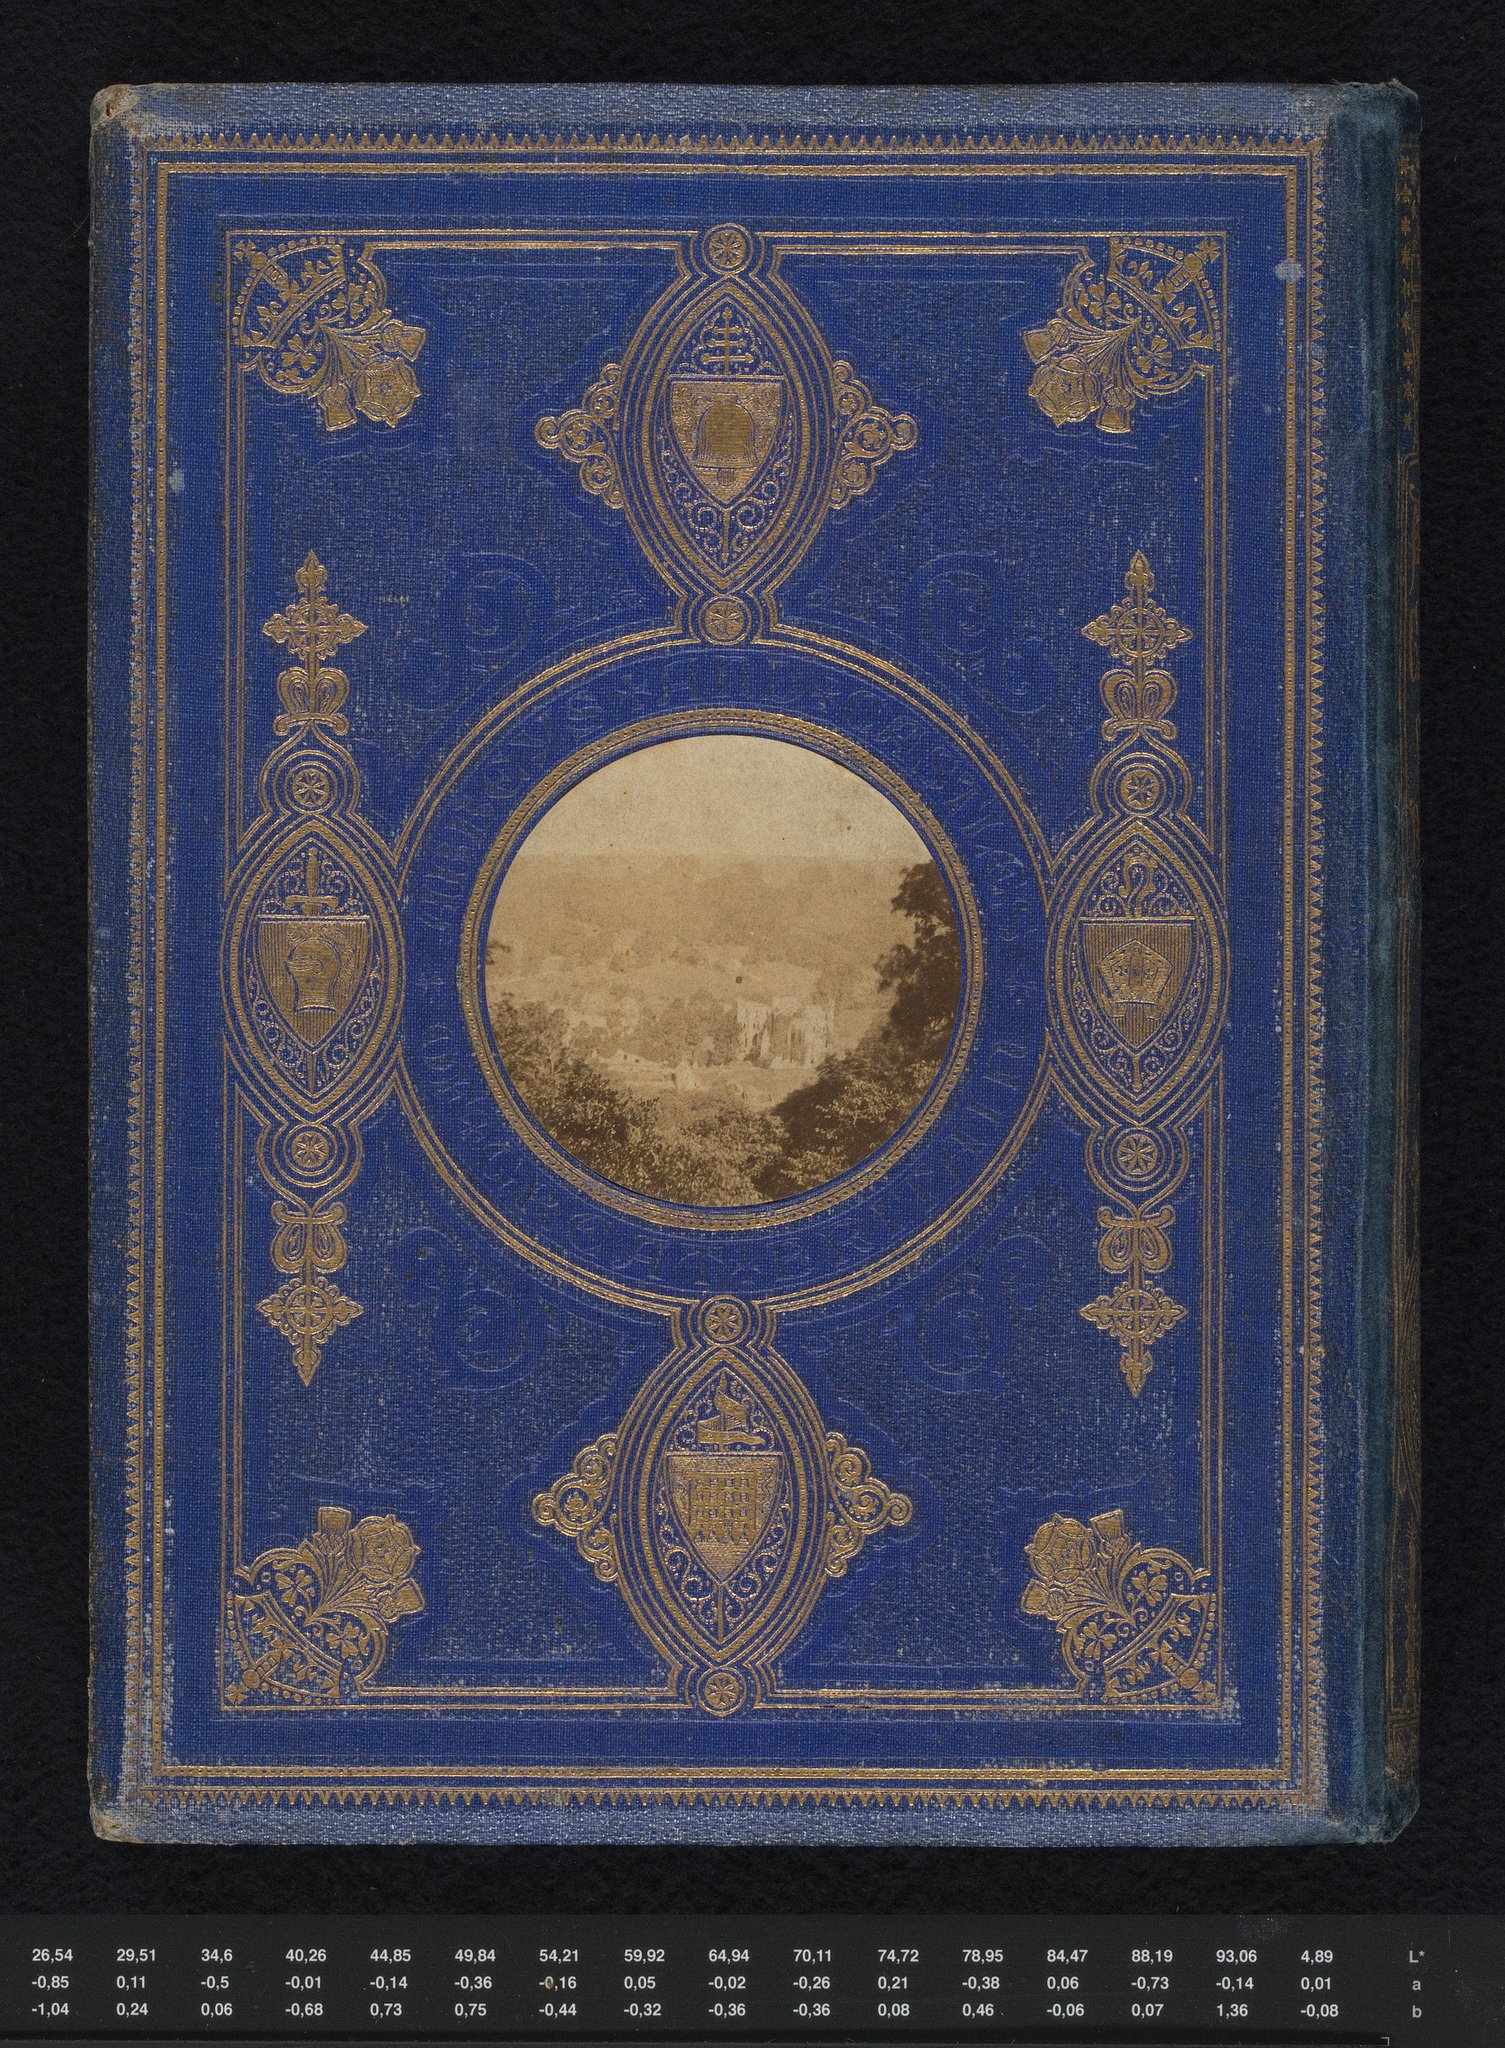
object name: photograph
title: Ruïne van een kathedraal in Groot Brittannië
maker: Anonymous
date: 1857-1862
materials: paper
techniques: albumen print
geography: great britain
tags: ruin of church, monastery, etc., great britain